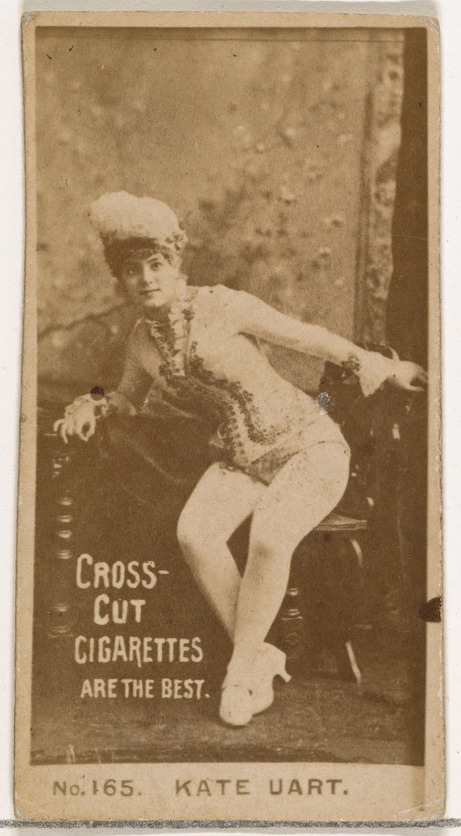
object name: print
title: Card Number 165, Kate Uart, from the Actors and Actresses series (N145-2) issued by Duke Sons & Co. to promote Cross Cut Cigarettes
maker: w. duke, sons & co.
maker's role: publisher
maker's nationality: american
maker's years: 1870-1920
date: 1880-1889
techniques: albumen silver print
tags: portraits,women,actresses